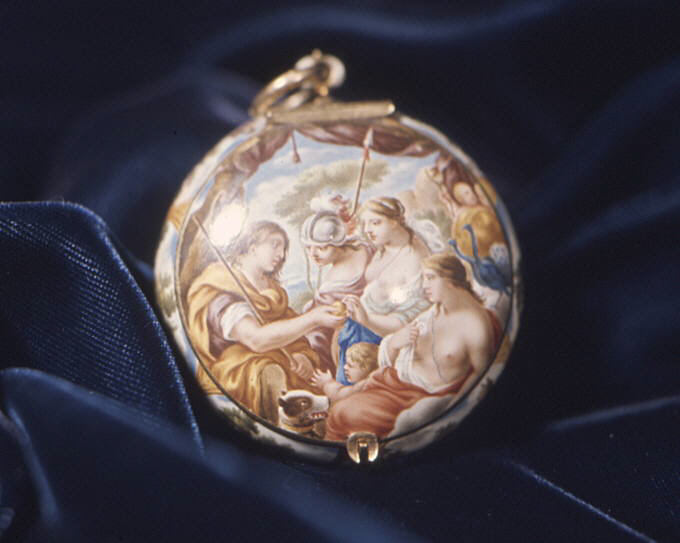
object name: watch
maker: g. gamos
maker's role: maker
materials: enamel, metal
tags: children,women,female nudes,dogs